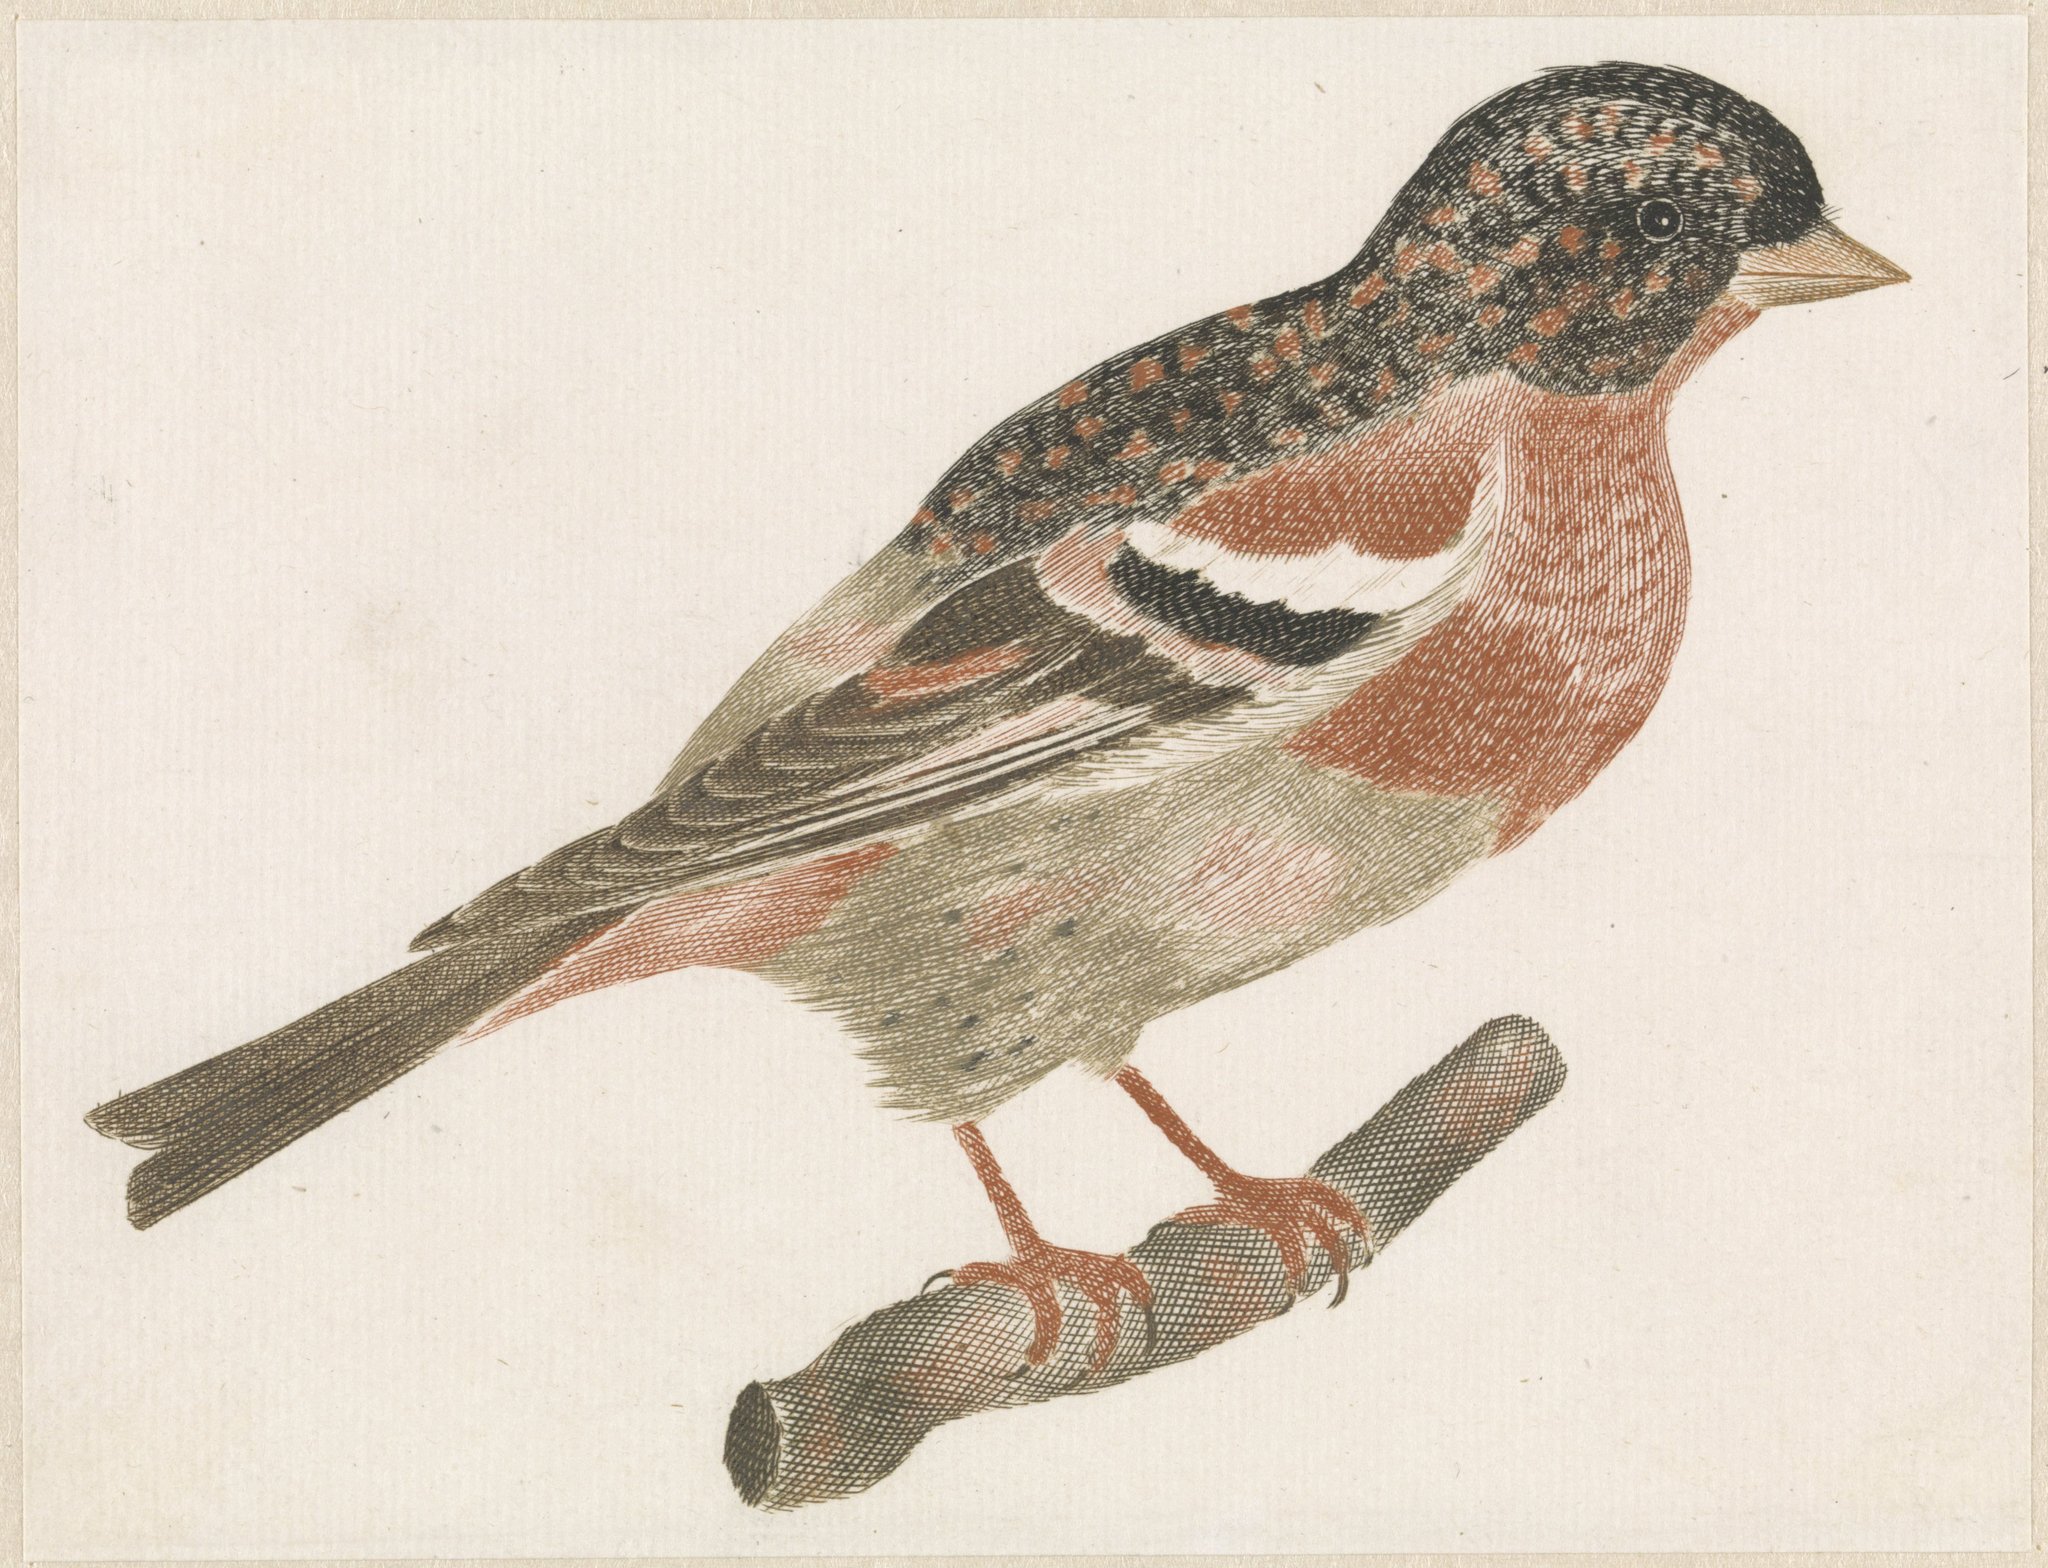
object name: print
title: Vogel op een tak naar rechts, mogelijk een goudvink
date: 1688-1698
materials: paper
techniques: printing, engraving, lithography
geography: netherlands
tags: song-birds: finch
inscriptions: collector's mark: Lugt 2228